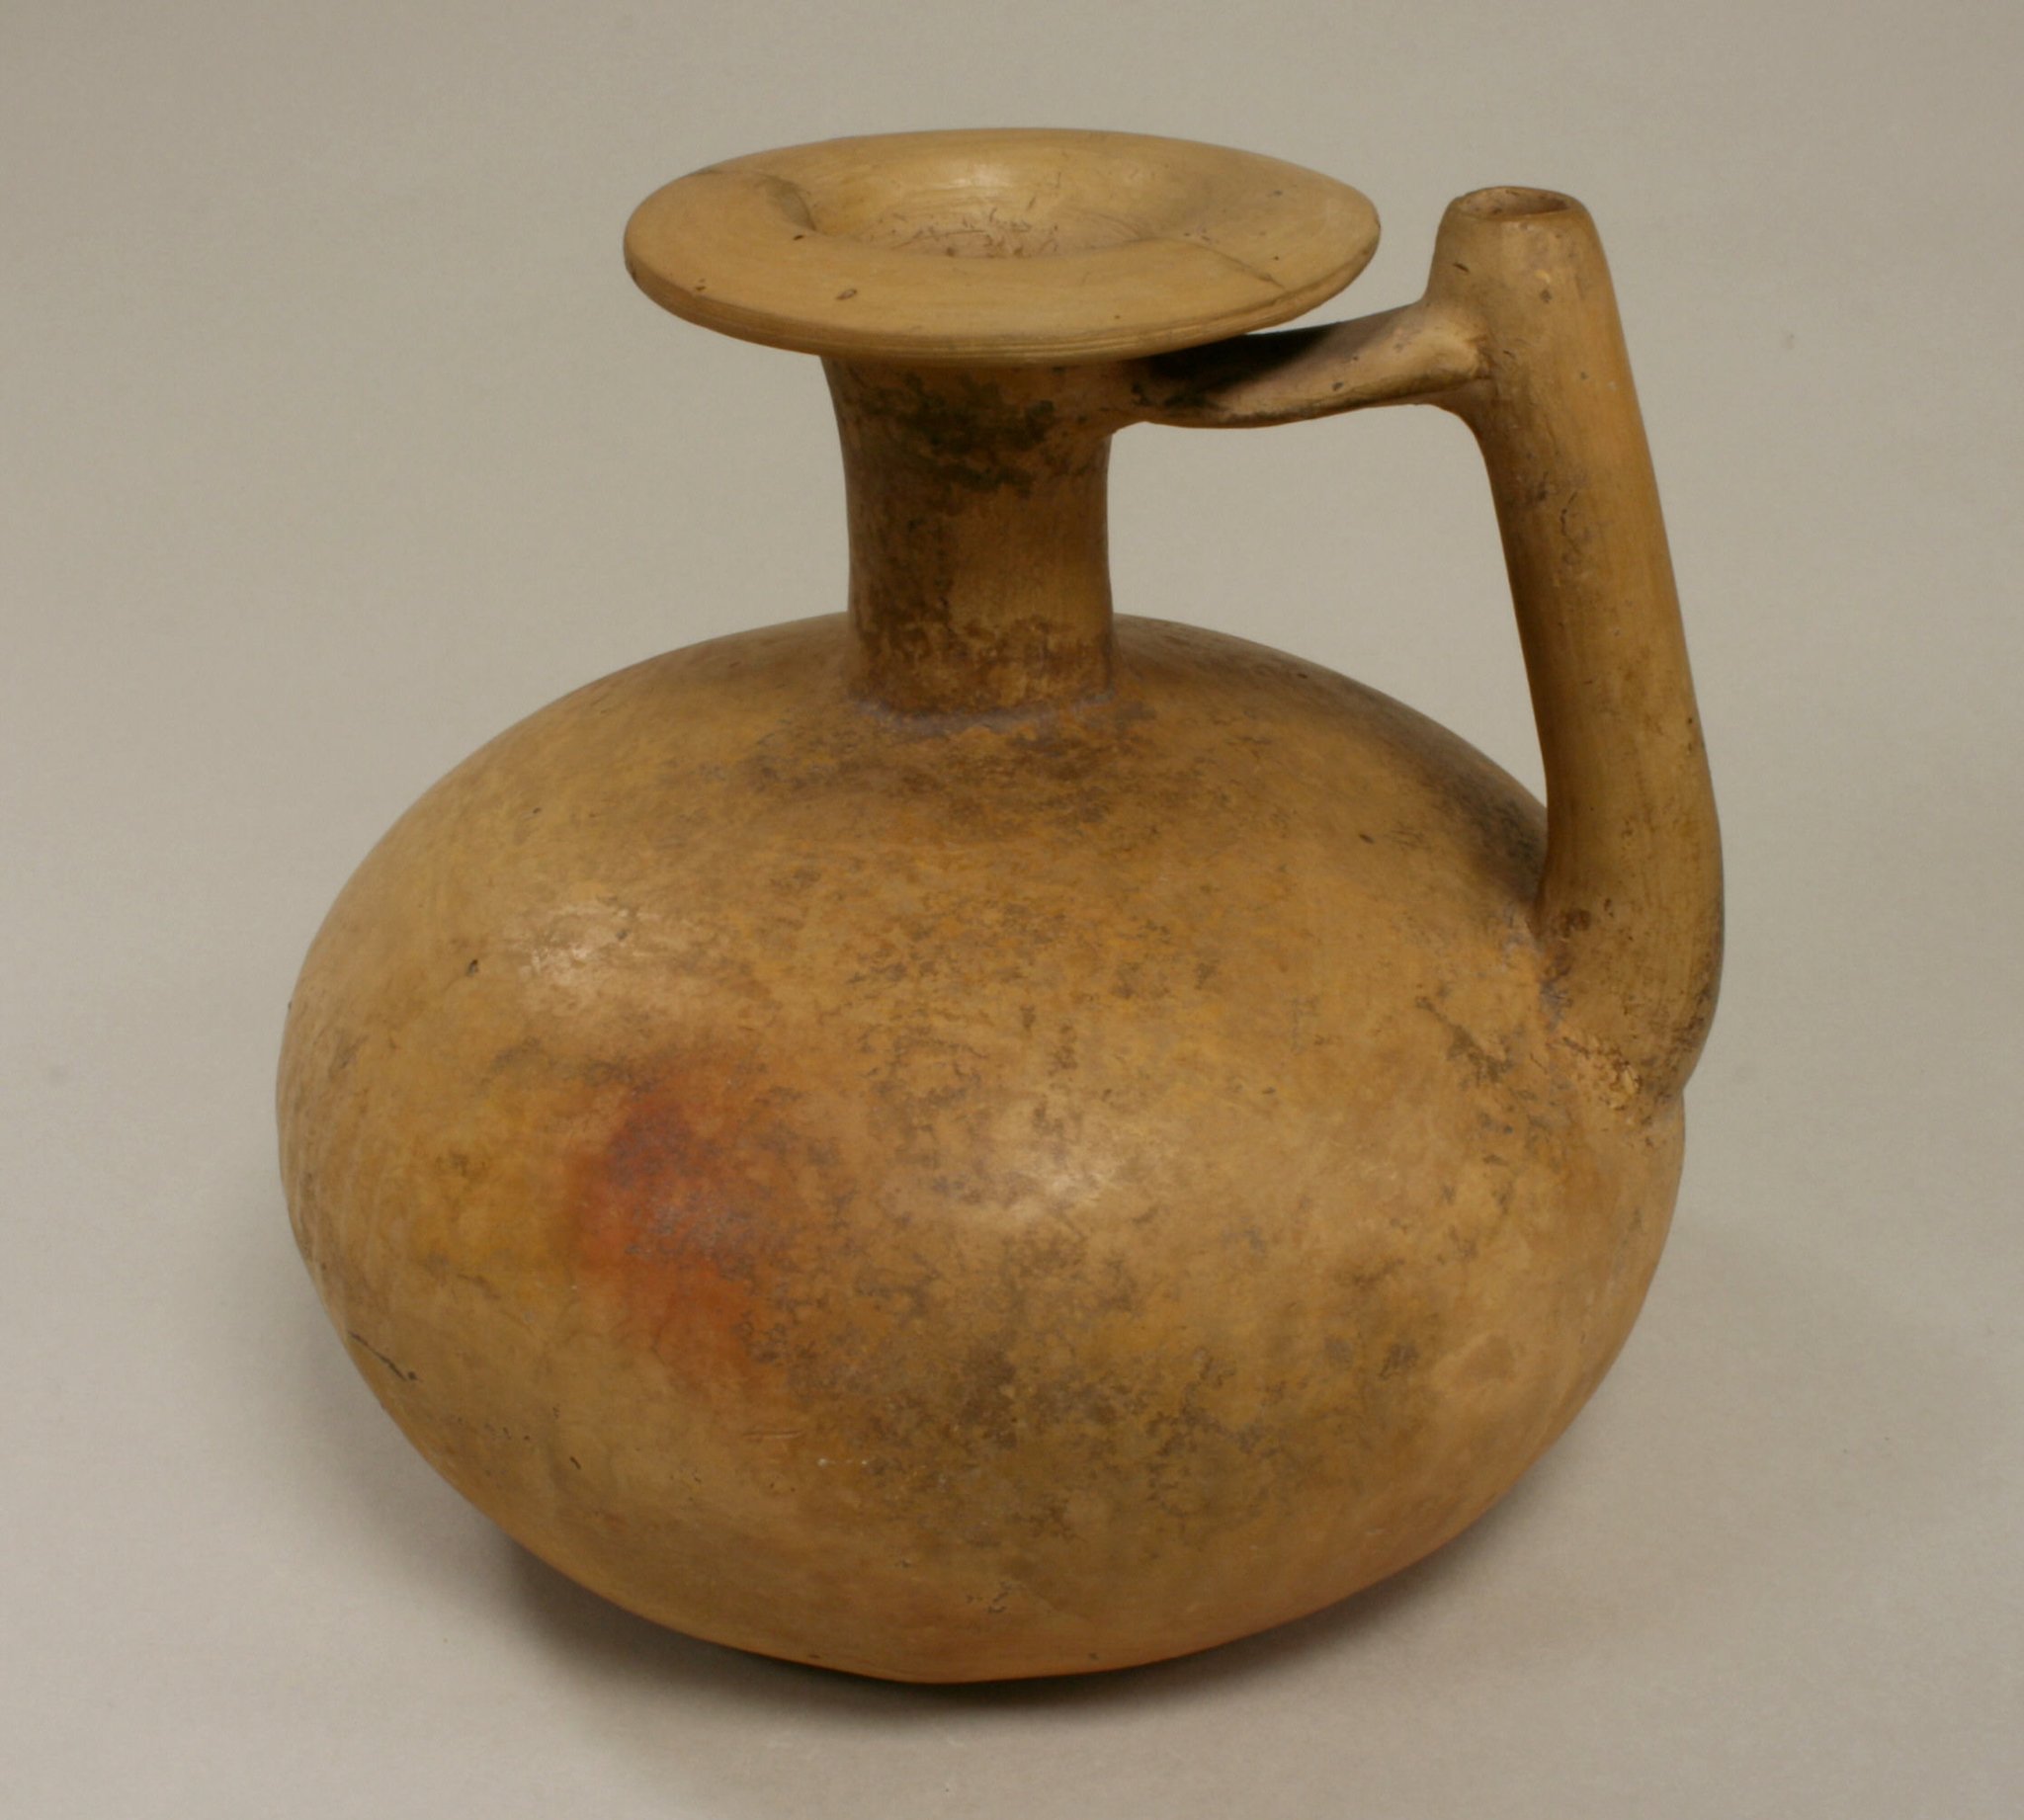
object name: bottle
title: Spouted Bottle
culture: mexican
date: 401-700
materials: ceramic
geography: mexico